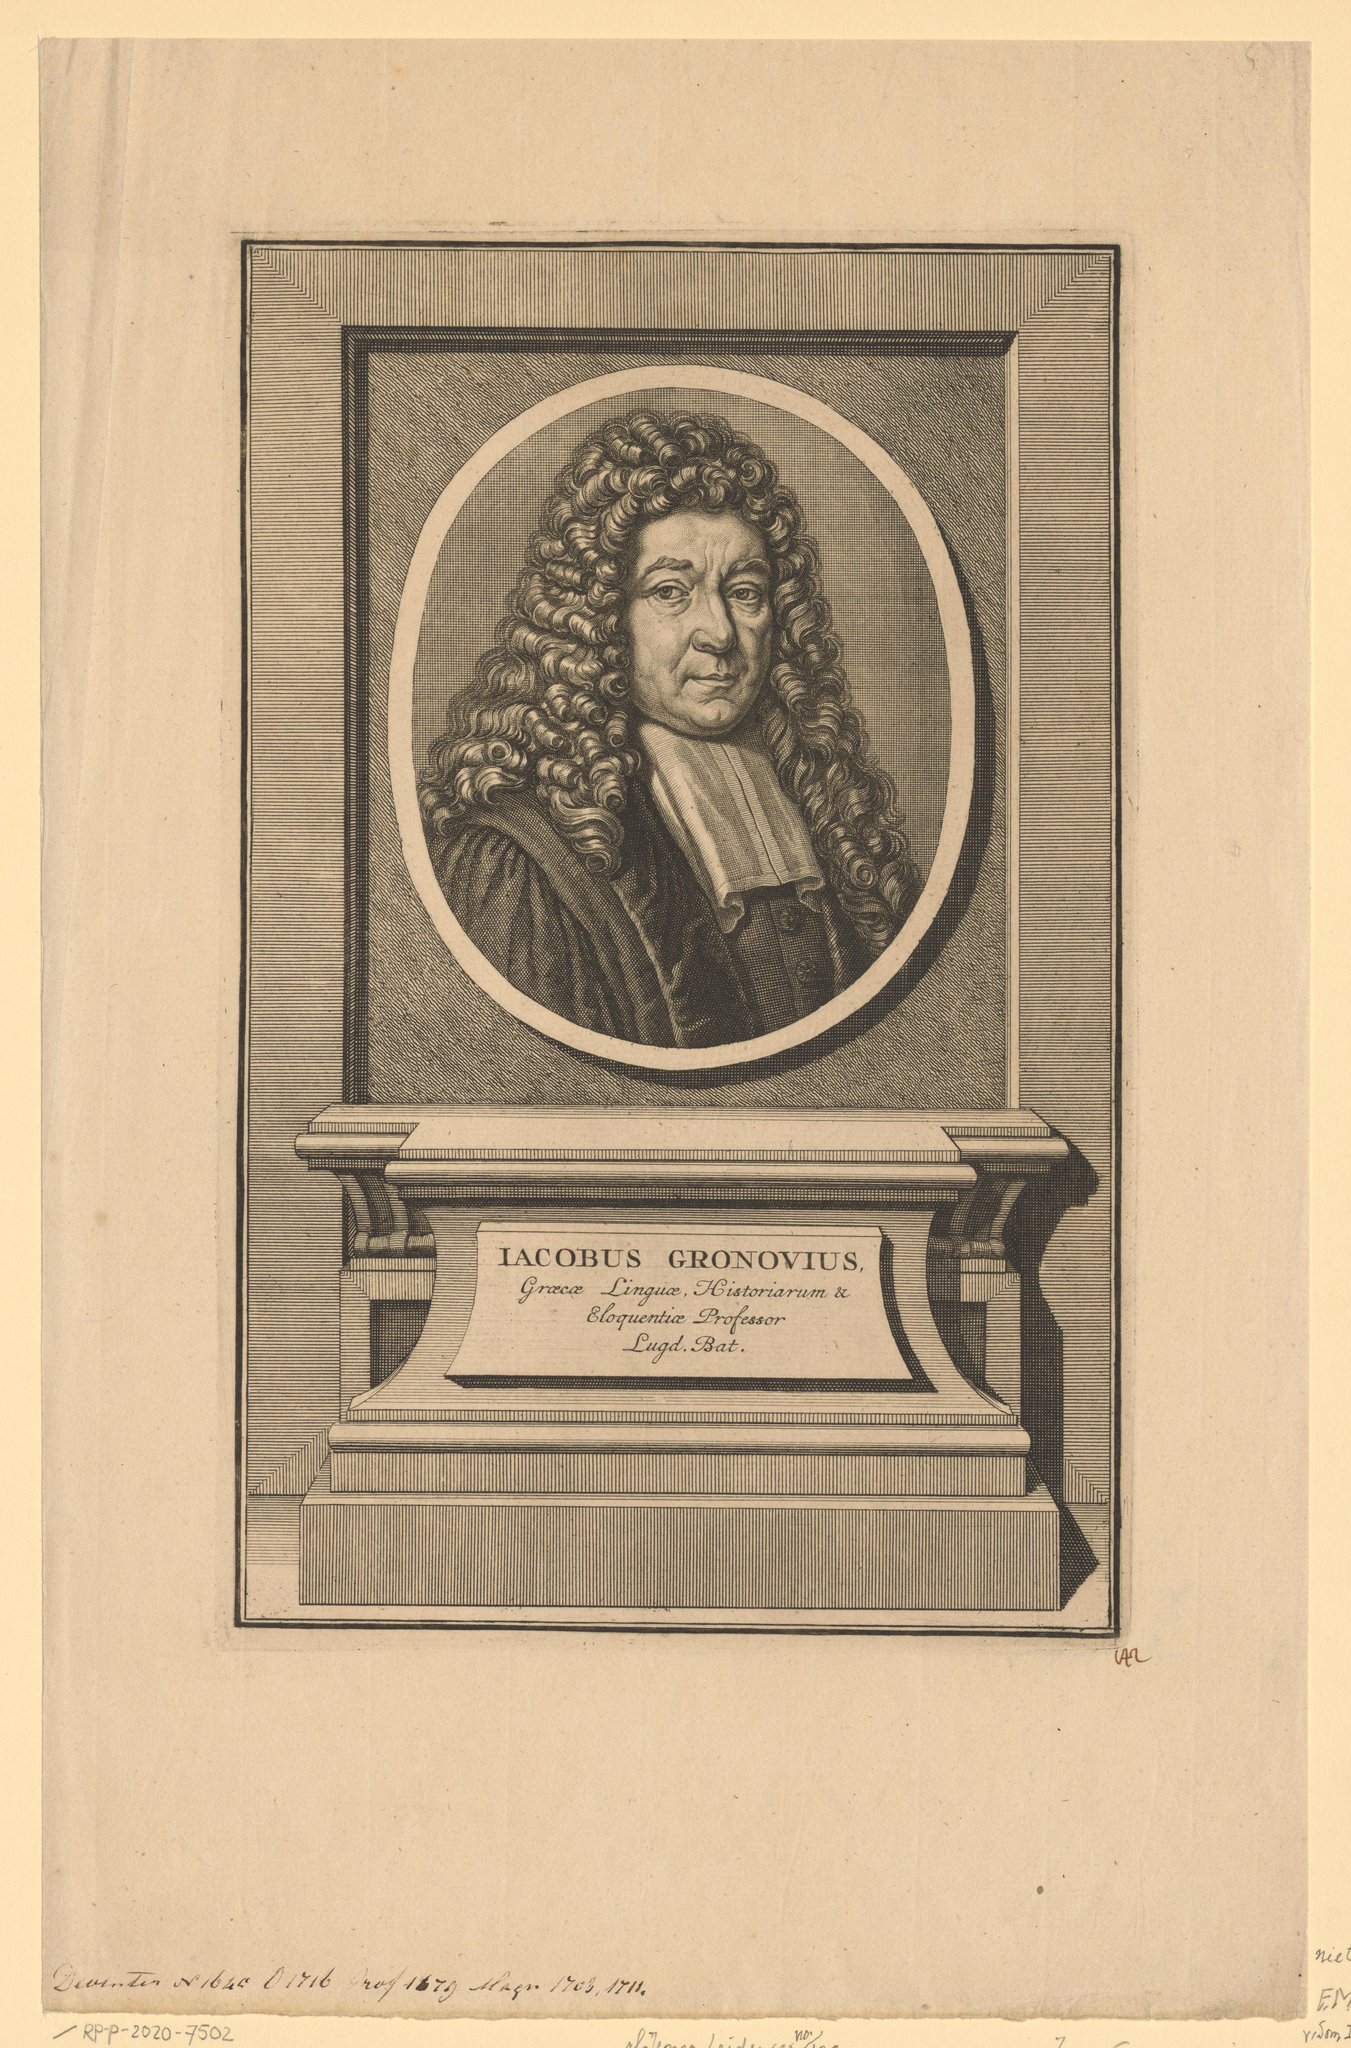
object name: print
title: Portret van Jacob Gronovius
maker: Anonymous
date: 1700-1800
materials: paper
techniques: engraving, etching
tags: leiden, jacob gronovius, historical persons, professor